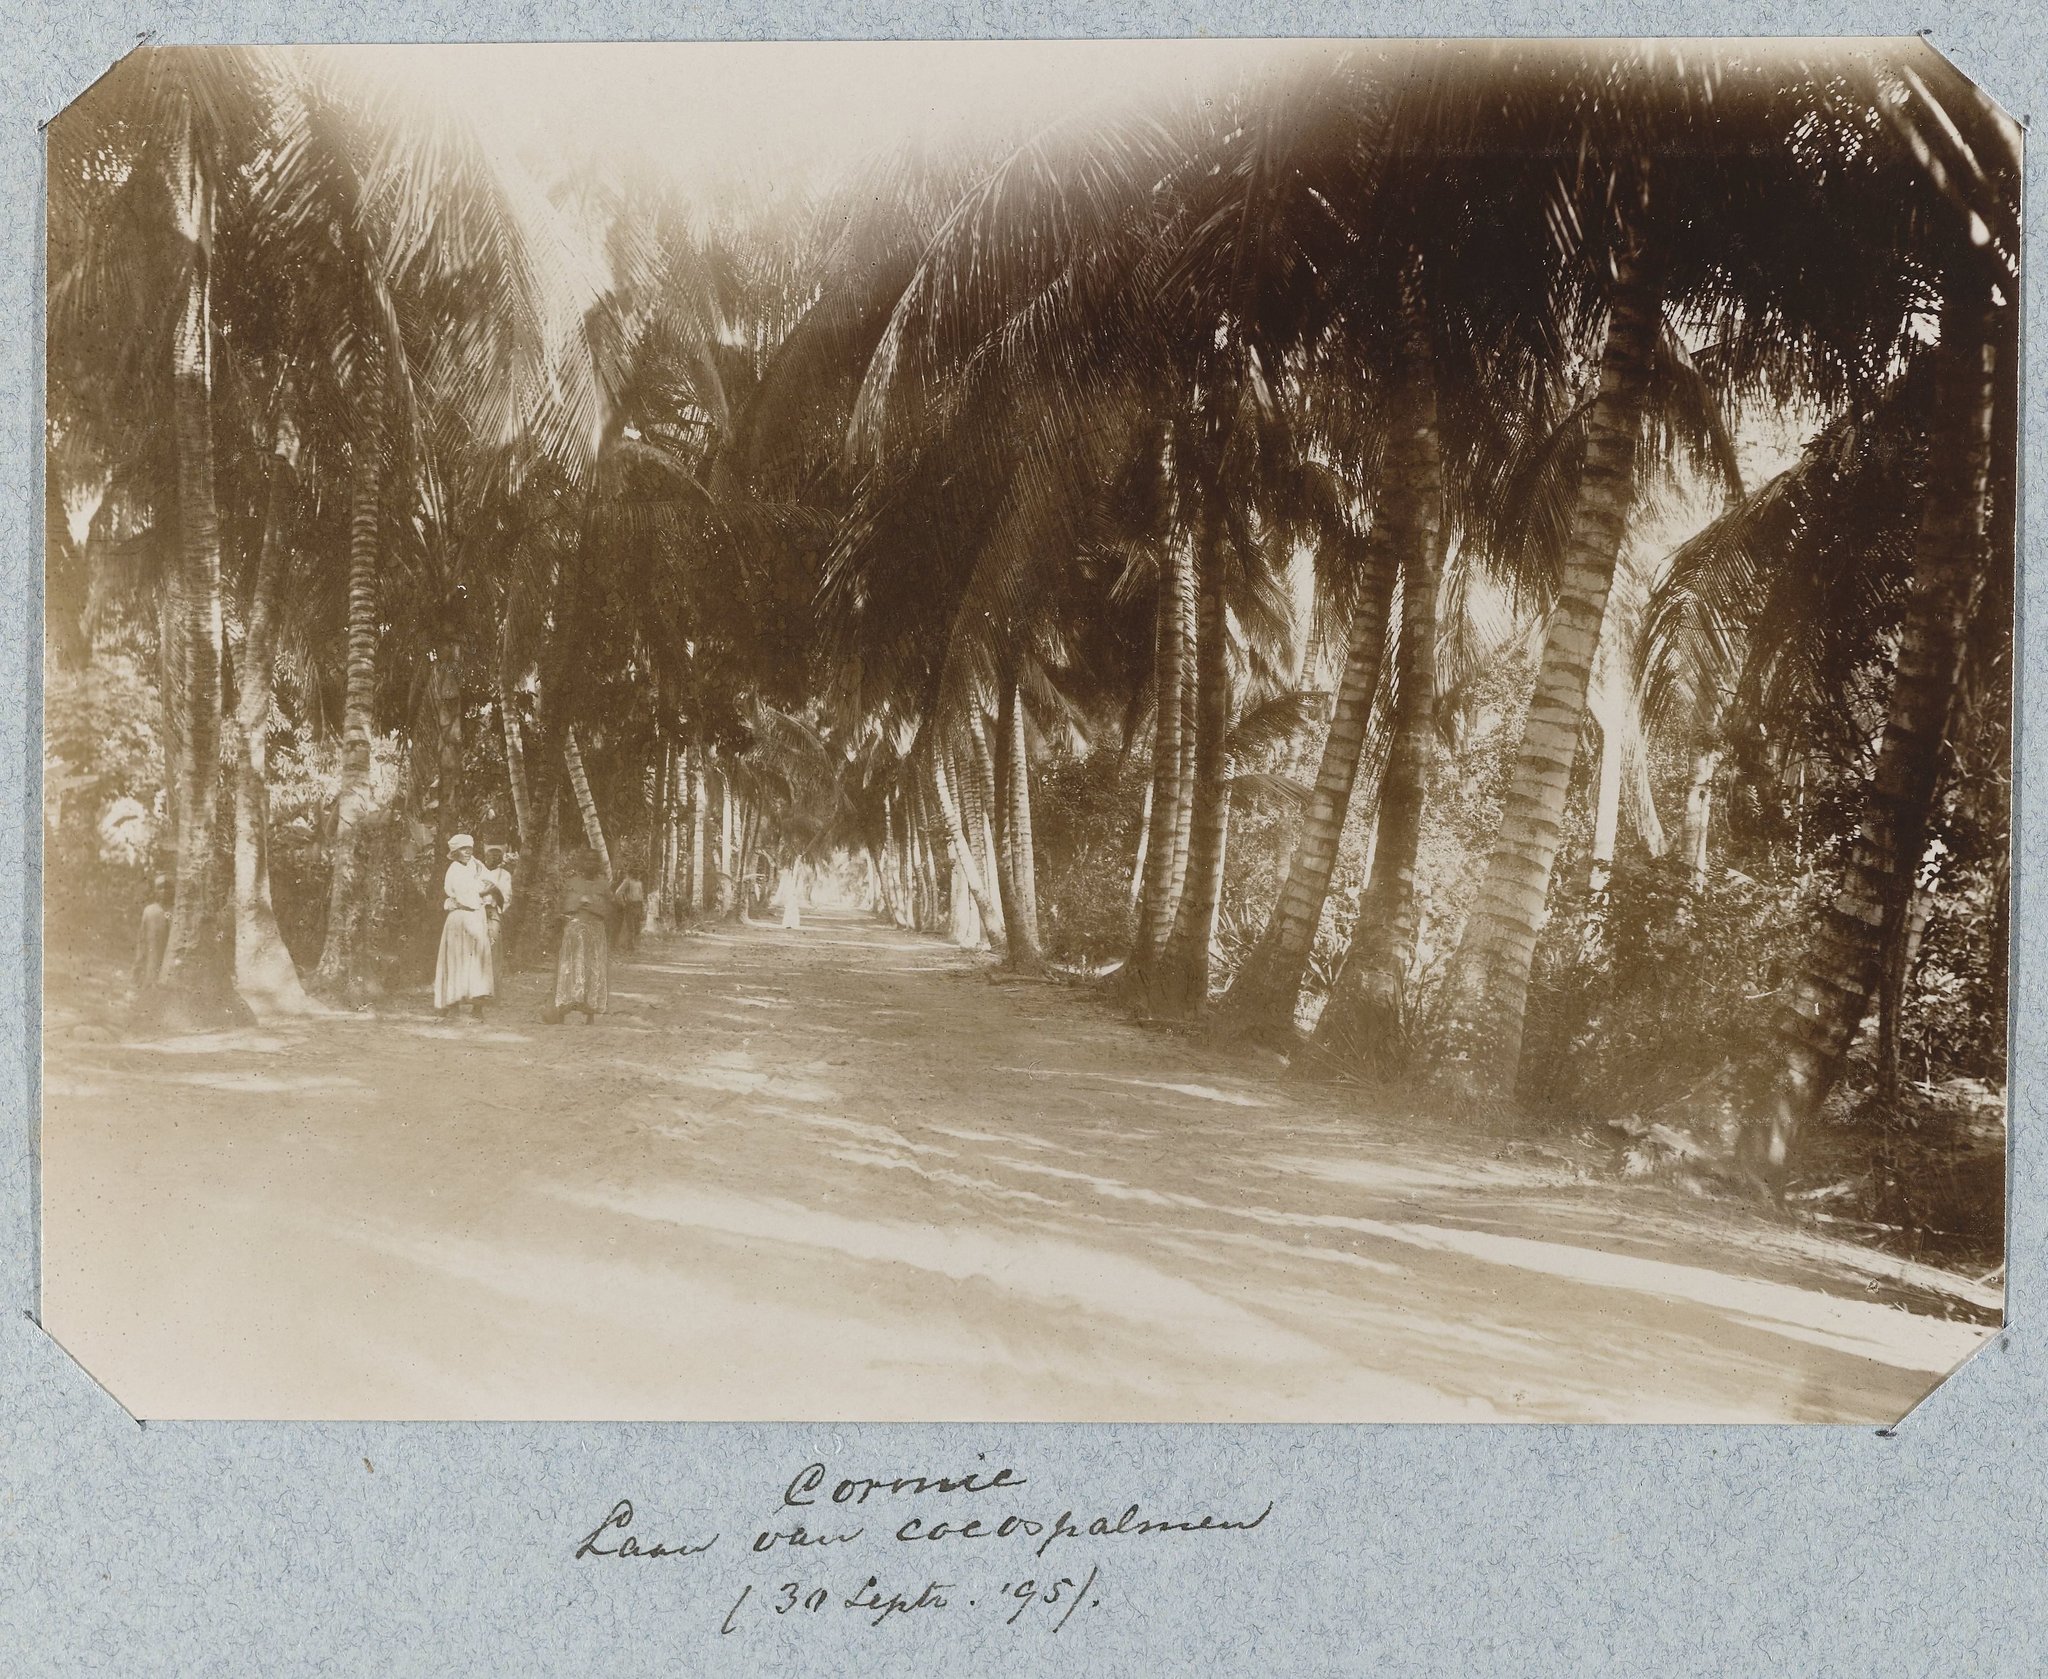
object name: photograph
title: Coronie / Laan van cocospalmen (30 Sept. '95)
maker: théodore van lelyveld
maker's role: painter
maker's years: 1867-1954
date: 1895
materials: photographic support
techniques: collodion silver print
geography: suriname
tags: public road in village (+ city(-scape) with figures, staffage)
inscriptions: inscription: ‘Coronie / Laan van cocospalmen (30 Sept. '95)’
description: Gezicht in een laan in Coronie met aan weerszijden kokospalmen. Links enkele vrouwen. Fotoafdruk in een fotoalbum van Théodore van Lelyveld over Suriname uit 1895-1898.